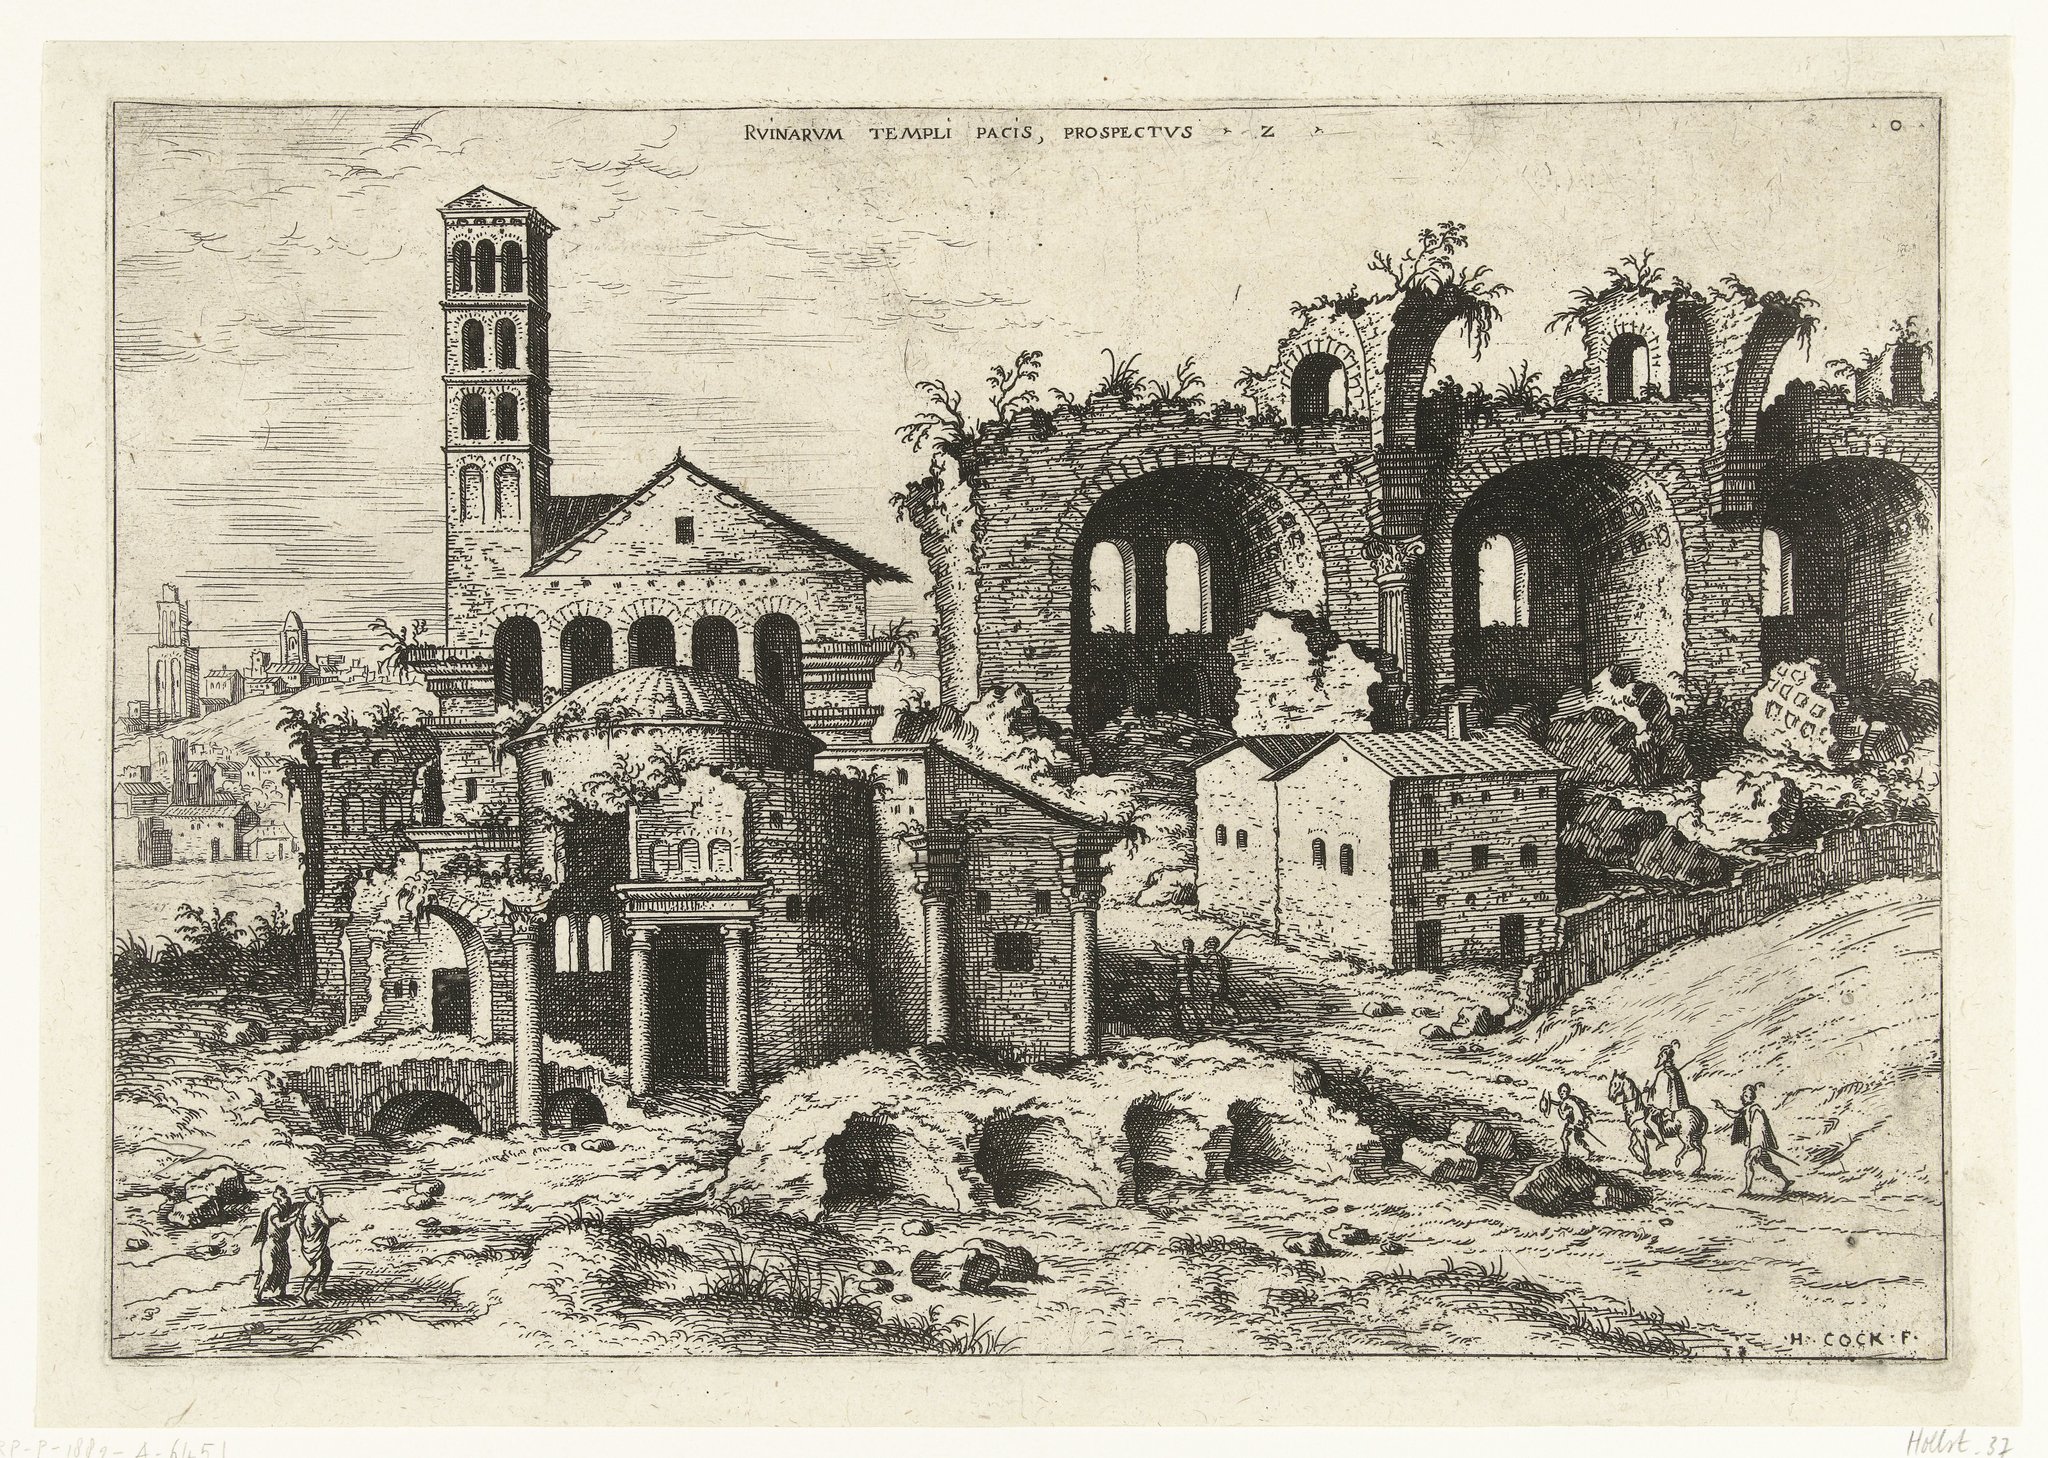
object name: print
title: Rvinarvm Templi Pacis (...)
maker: hieronymus cock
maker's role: print maker, publisher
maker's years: 1518-1570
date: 1551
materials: paper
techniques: etching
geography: antwerp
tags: ruin of a building ~ architecture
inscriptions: collector's mark: Lugt 2228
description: Gezicht op de ruïnes van de tempel van Romulus met erachter de kerk van de heiligen Cosmas en Daminanus. Rechts de ruïnes van de basiliek van Constantijn. Op een weg tussen de gebouwen rijdt een soldaat, naast hem lopen twee voetsoldaten. Prent uit een serie van 25 prenten met Romeinse ruïnes.